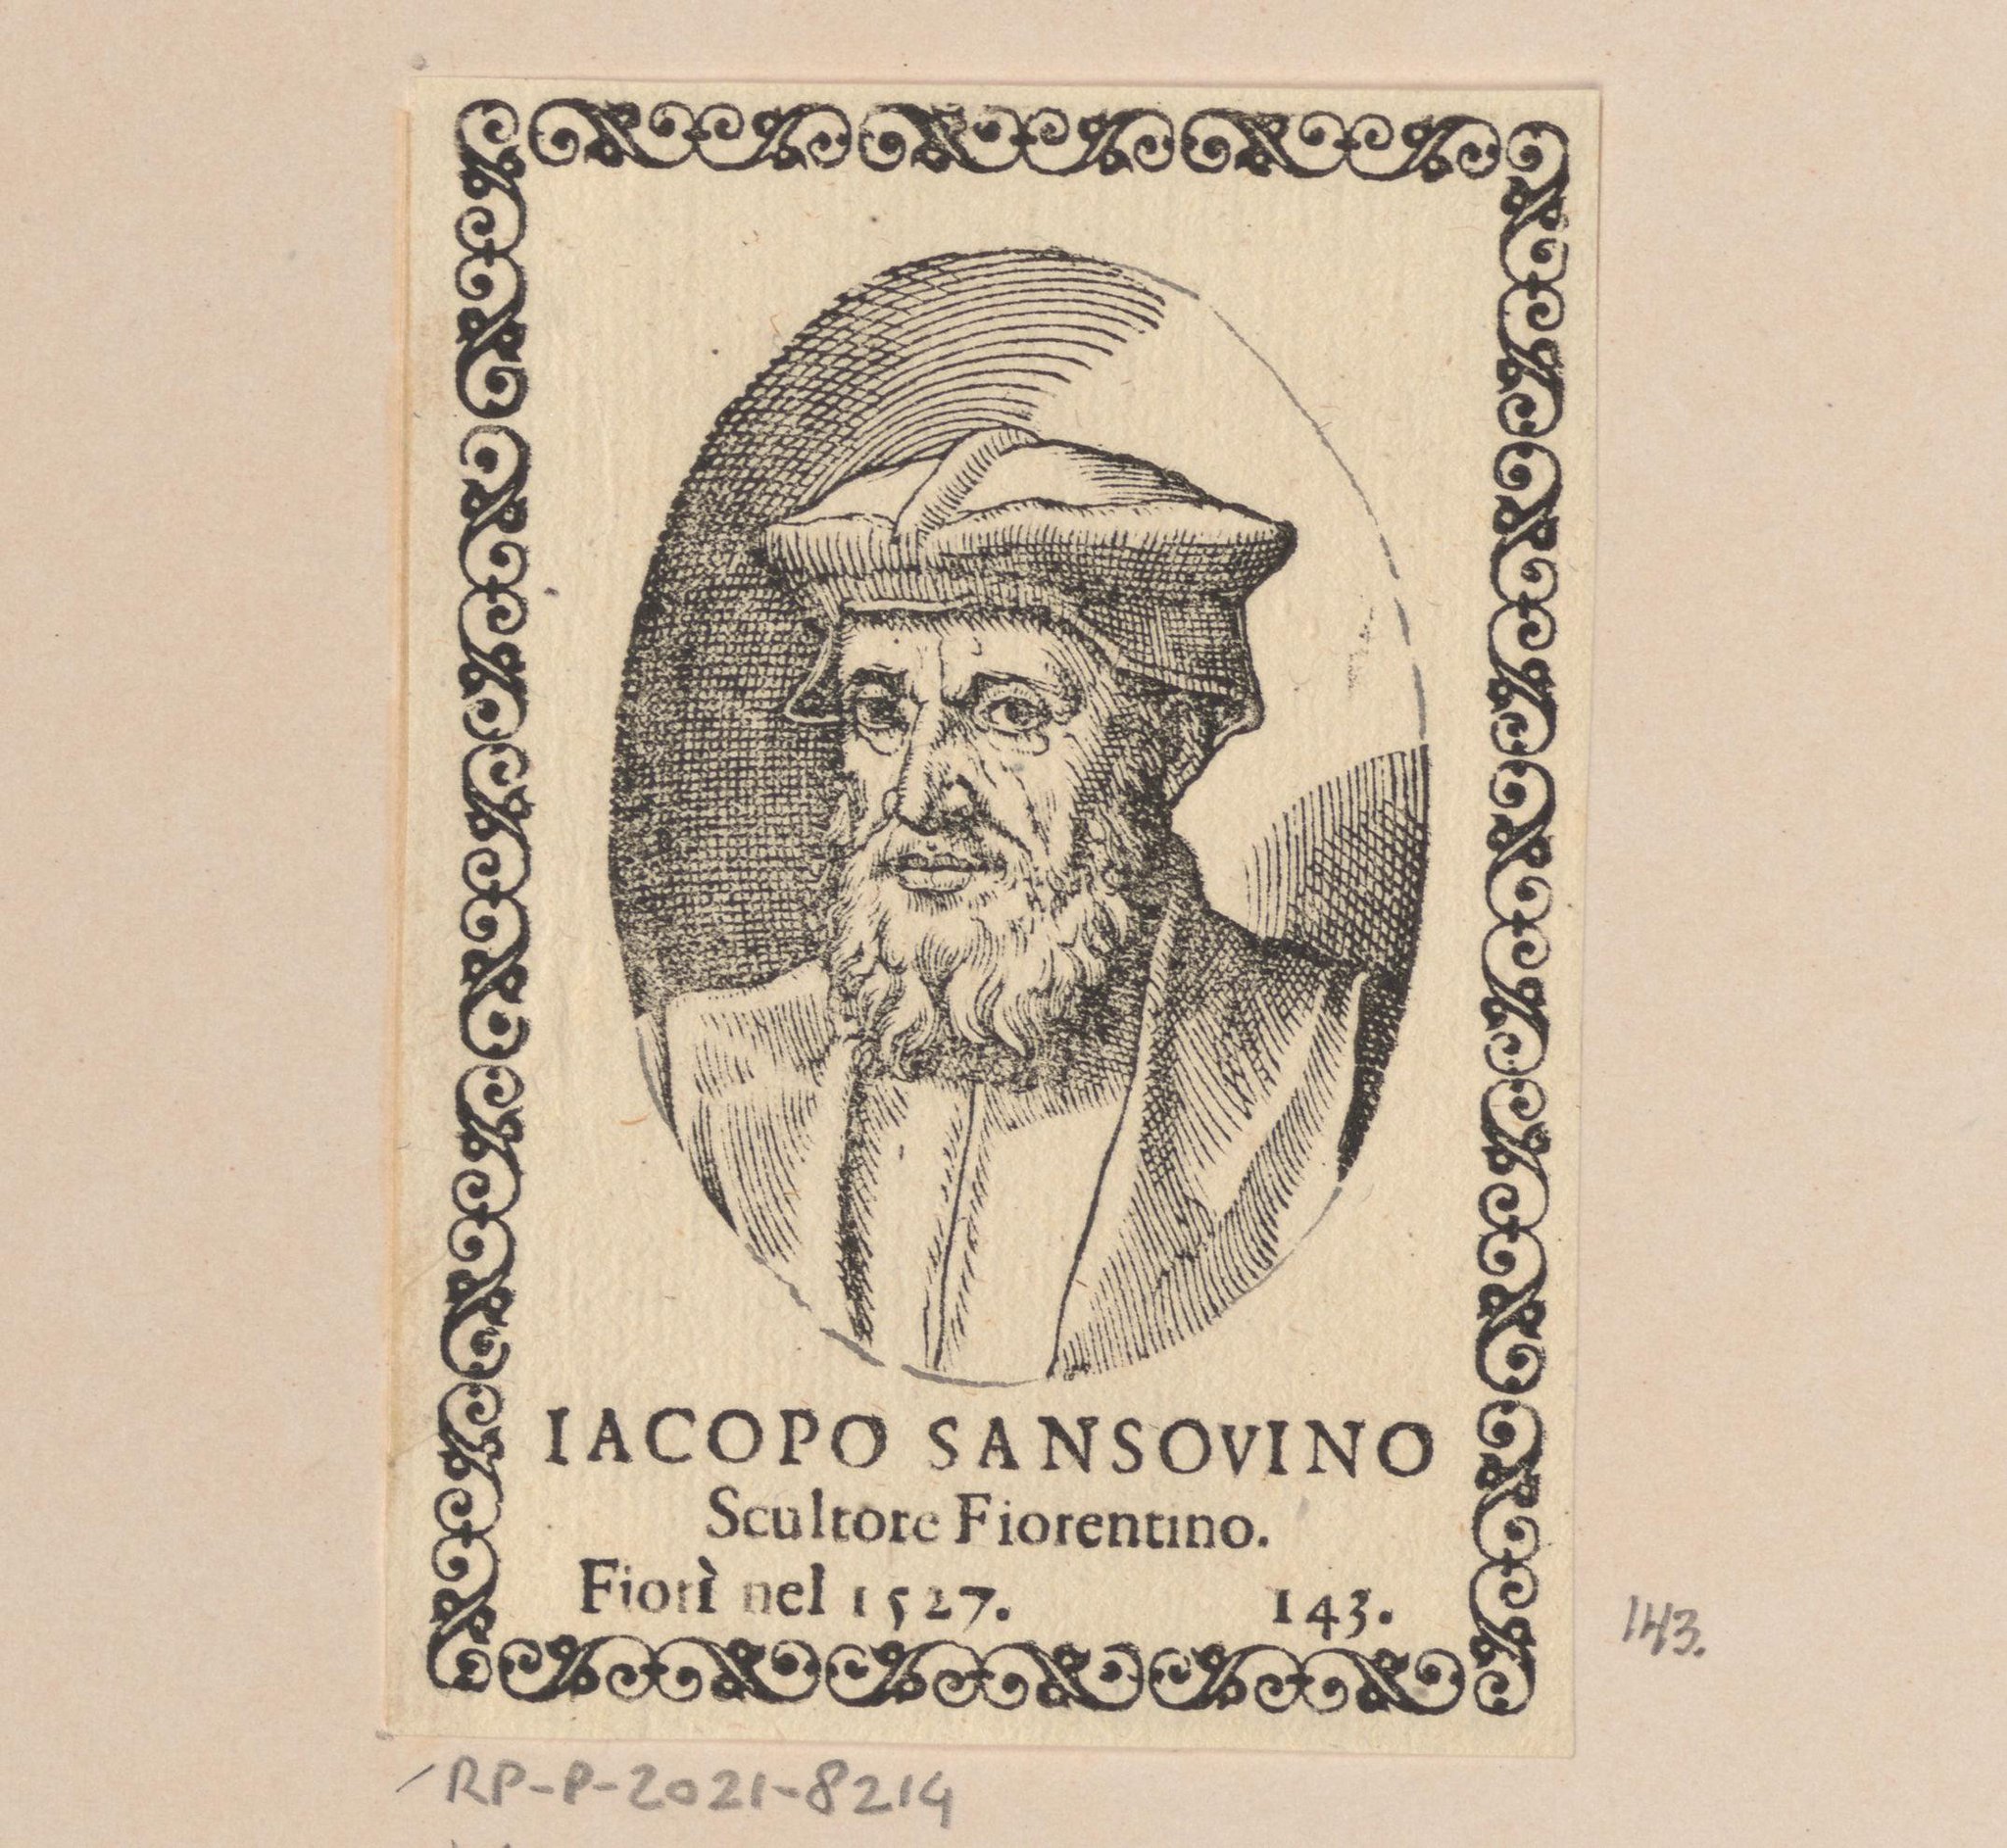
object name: print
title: Portret van Jacopo Sansovino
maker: cristoforo coriolano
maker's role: print maker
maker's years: 1540-1610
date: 1568-1650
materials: paper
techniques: letterpress printing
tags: venice, sculptor, jacopo tatti sansovino, portrait, self-portrait of sculptor, historical persons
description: Prent komt uit een editie van Vasari's 'Vite'. Prent met een andere omlijsting gebruikt in: Vasari, Giorgio. Le vite de' piu eccellenti pittori scultori, e architettori. Florence: Filippo Giunta, 1568. En mogelijk in de editie uit 1647.